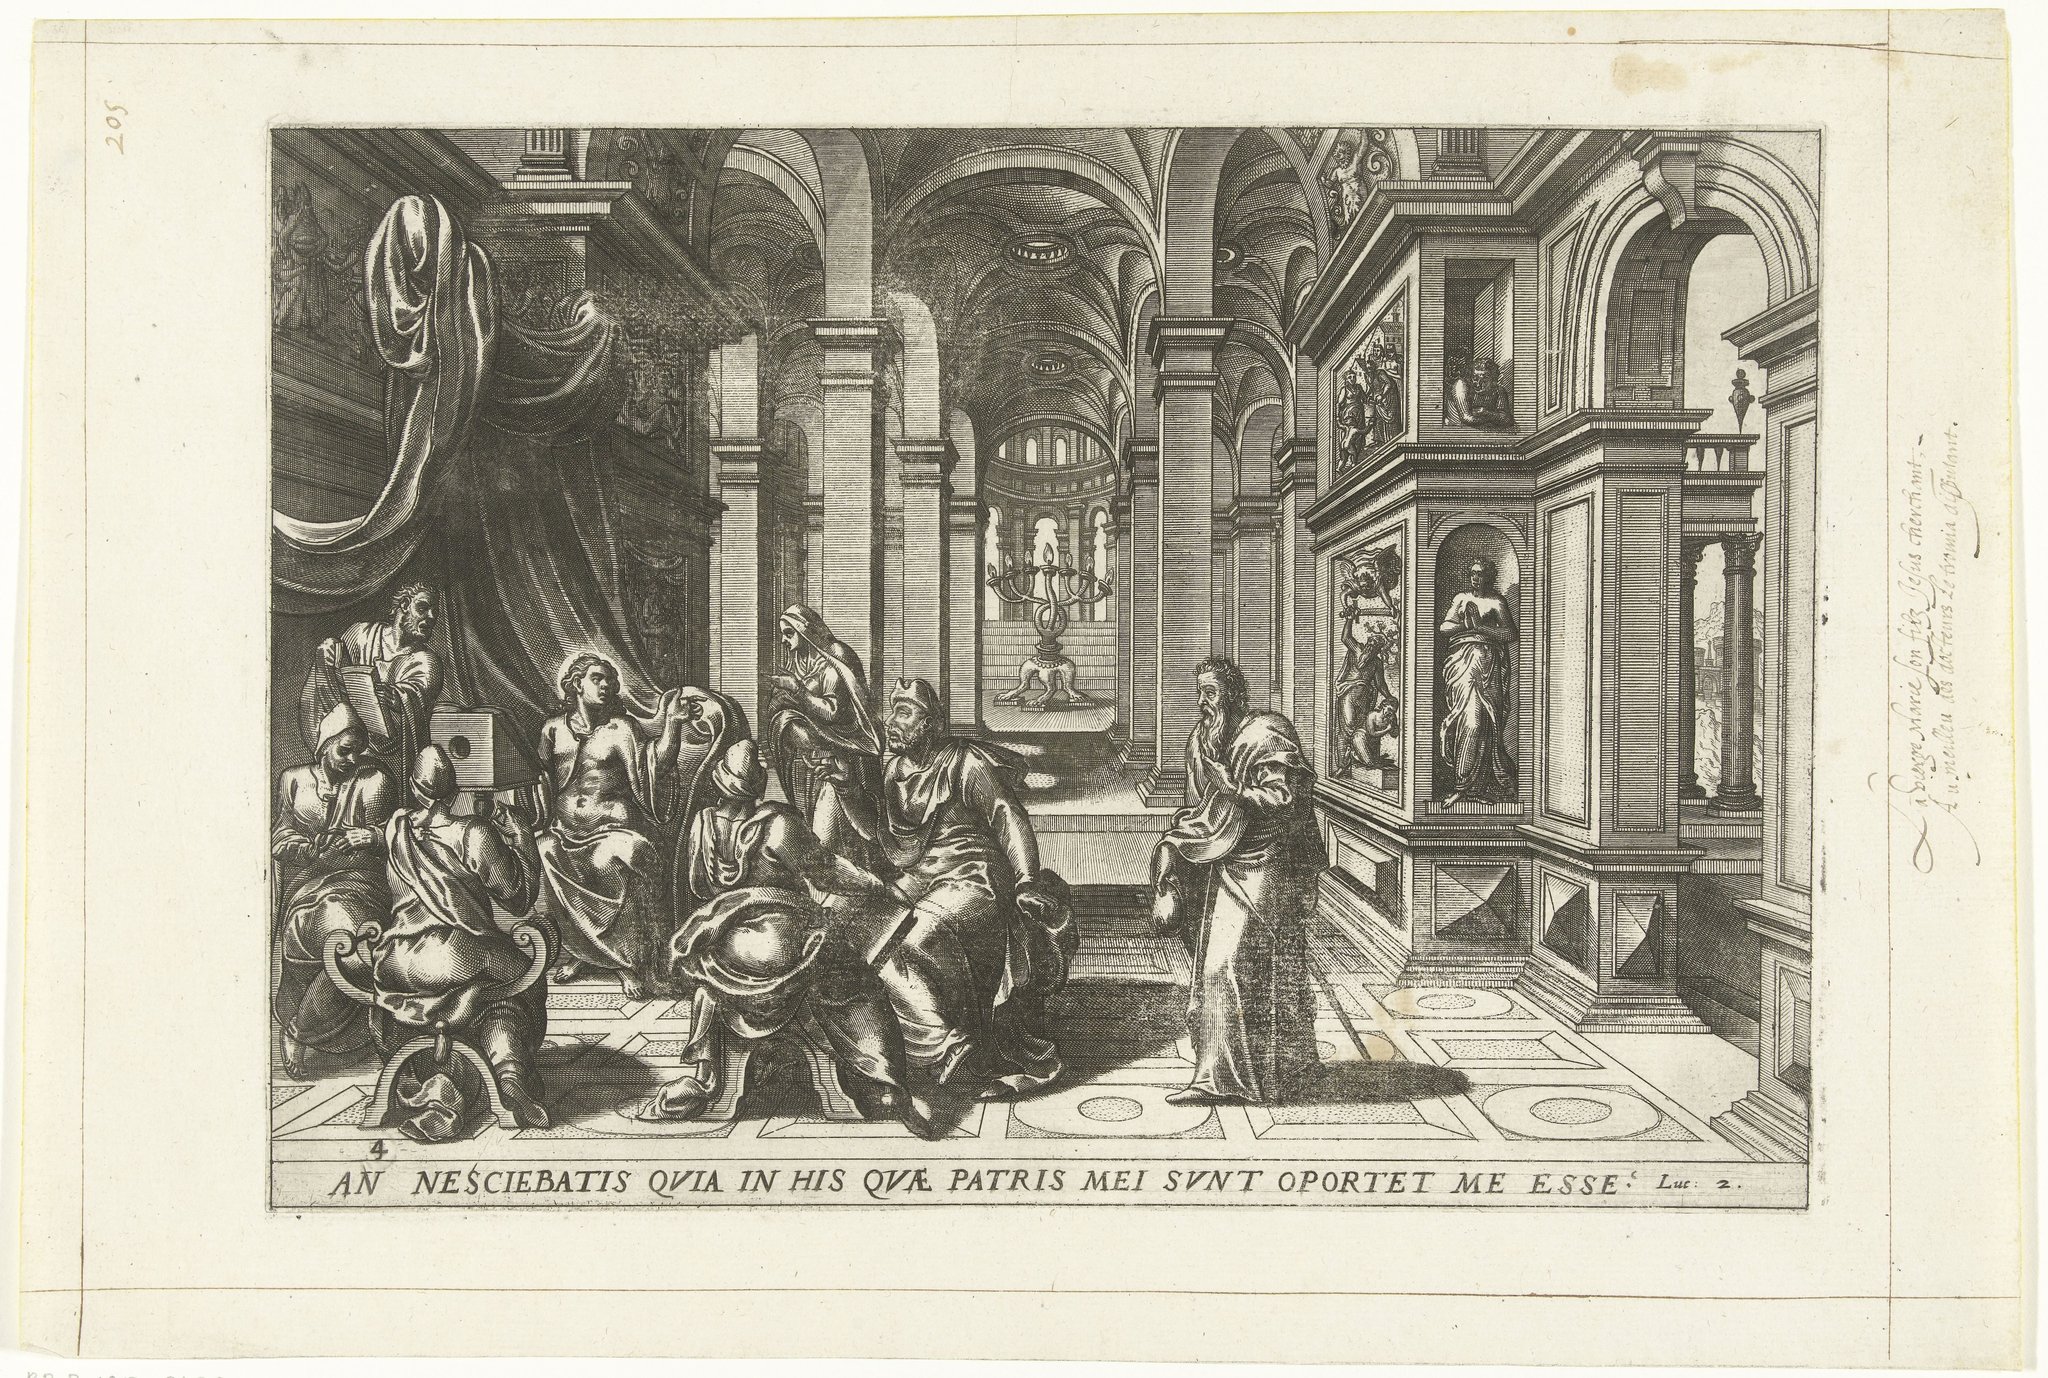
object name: print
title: Twaalfjarige Christus in de tempel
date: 1572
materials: paper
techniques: engraving, etching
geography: antwerp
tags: christ's dispute with the doctors in the temple; he counts his arguments on his fingers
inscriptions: collector's mark: Lugt 2228, inscription: ‘La vierge Marie son fils Jesus cherchant [...]’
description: In een hoek van de tempel zit Christus tussen de schriftgeleerden en legt hen de schrift uit. Christus maakt een spreekgebaar. De overige mannen zoeken iets op in hun boeken of praten eveneens met elkaar. Jozef loopt de tempel binnen en vindt zijn zoon tussen de geleerden.